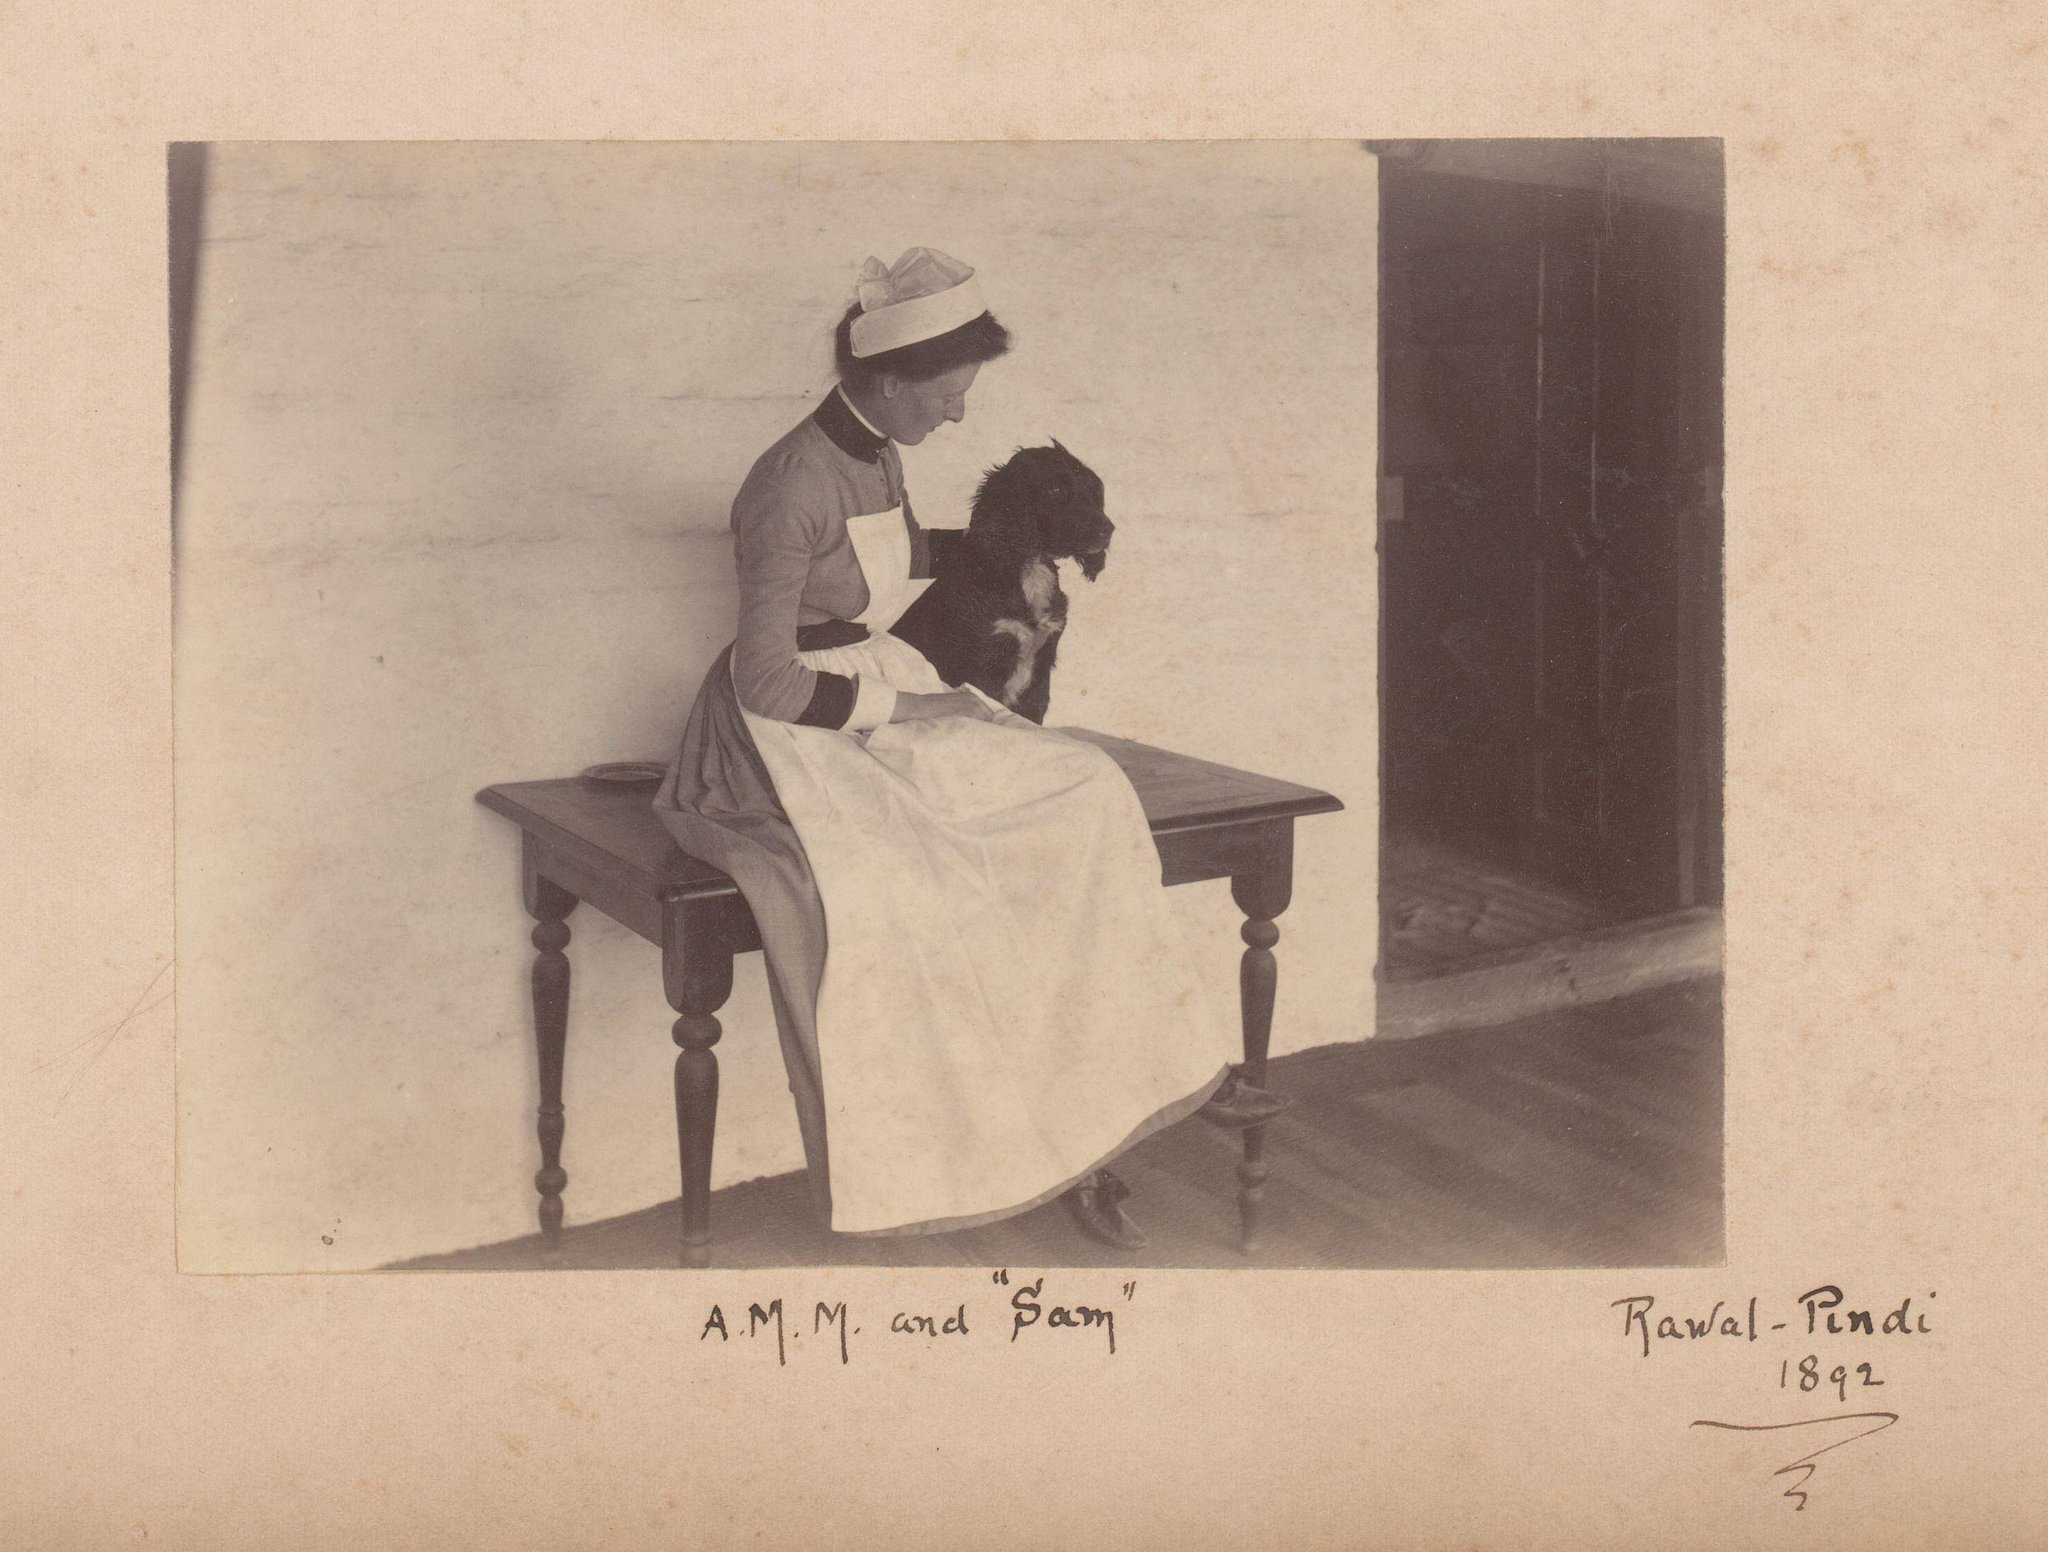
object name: album leaf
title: Zuster met hond poserend, Rawalpindi, Pakistan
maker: Anonymous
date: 1892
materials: cardboard, paper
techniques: albumen print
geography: pakistan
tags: pakistan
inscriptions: caption: ‘A.M.M. and "Sam"/ Rawal-Pindi/ 1892’